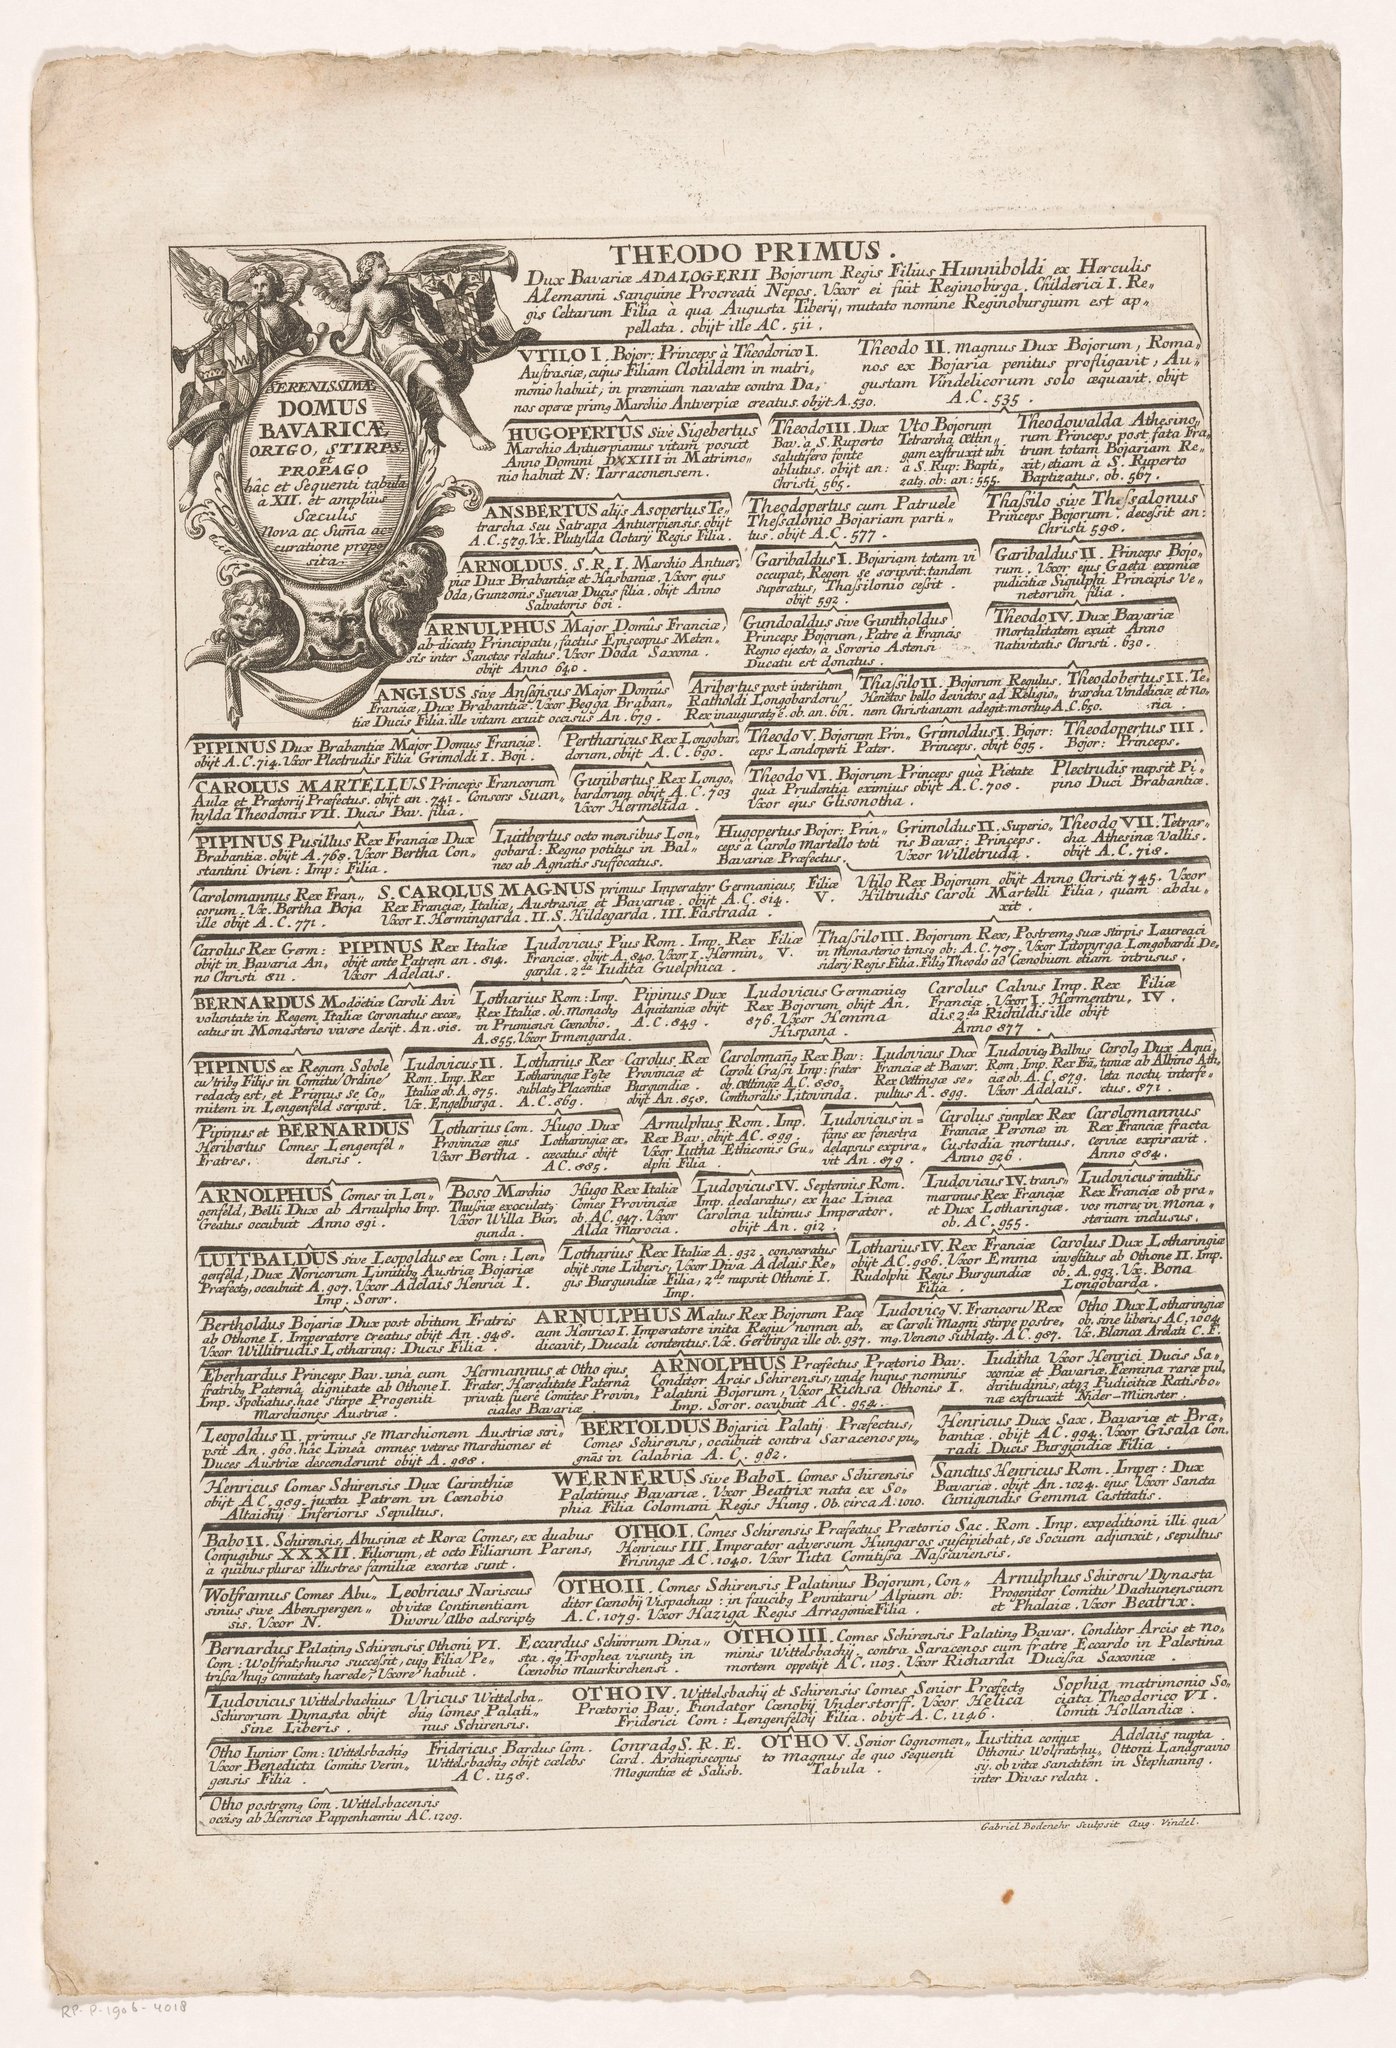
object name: print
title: Stamboom van het Beierse vorstenhuis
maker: gabriel bodenehr (i)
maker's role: print maker, publisher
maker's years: 1673-1765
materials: paper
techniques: etching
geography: augsburg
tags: family lineage, pedigree, genealogical tree or table, armorial bearing, heraldry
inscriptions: collector's mark: Lugt 2228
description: Eerste deel van een tweedelige stamboom van het Beierse vorstenhuis.